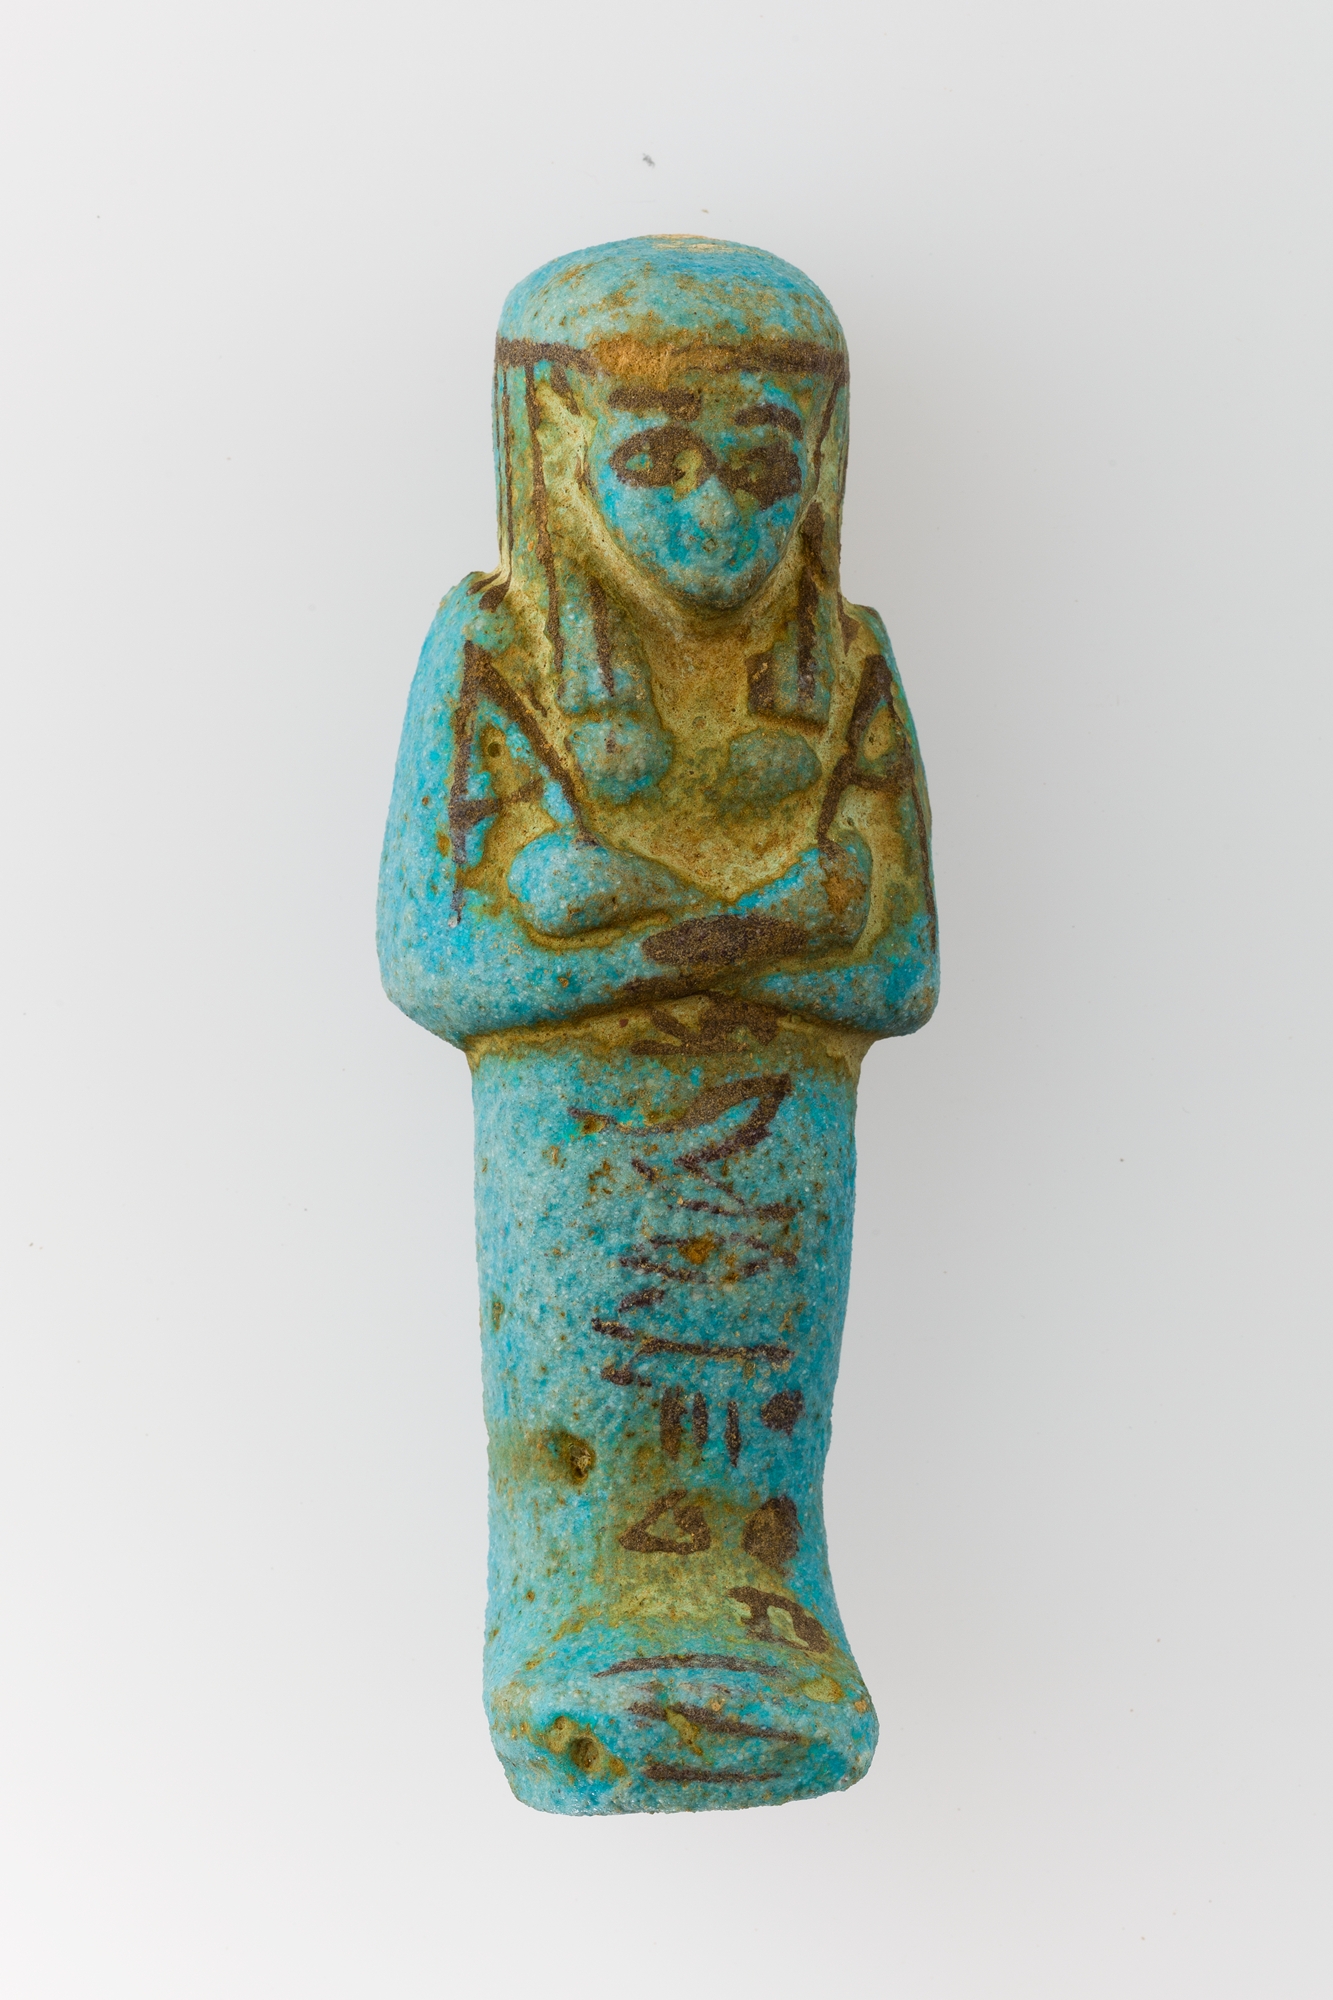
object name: shabti, henettawy c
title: Worker Shabti of Henettawy (C), Daughter of Isetemkheb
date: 990-970 BCE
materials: faience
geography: egypt